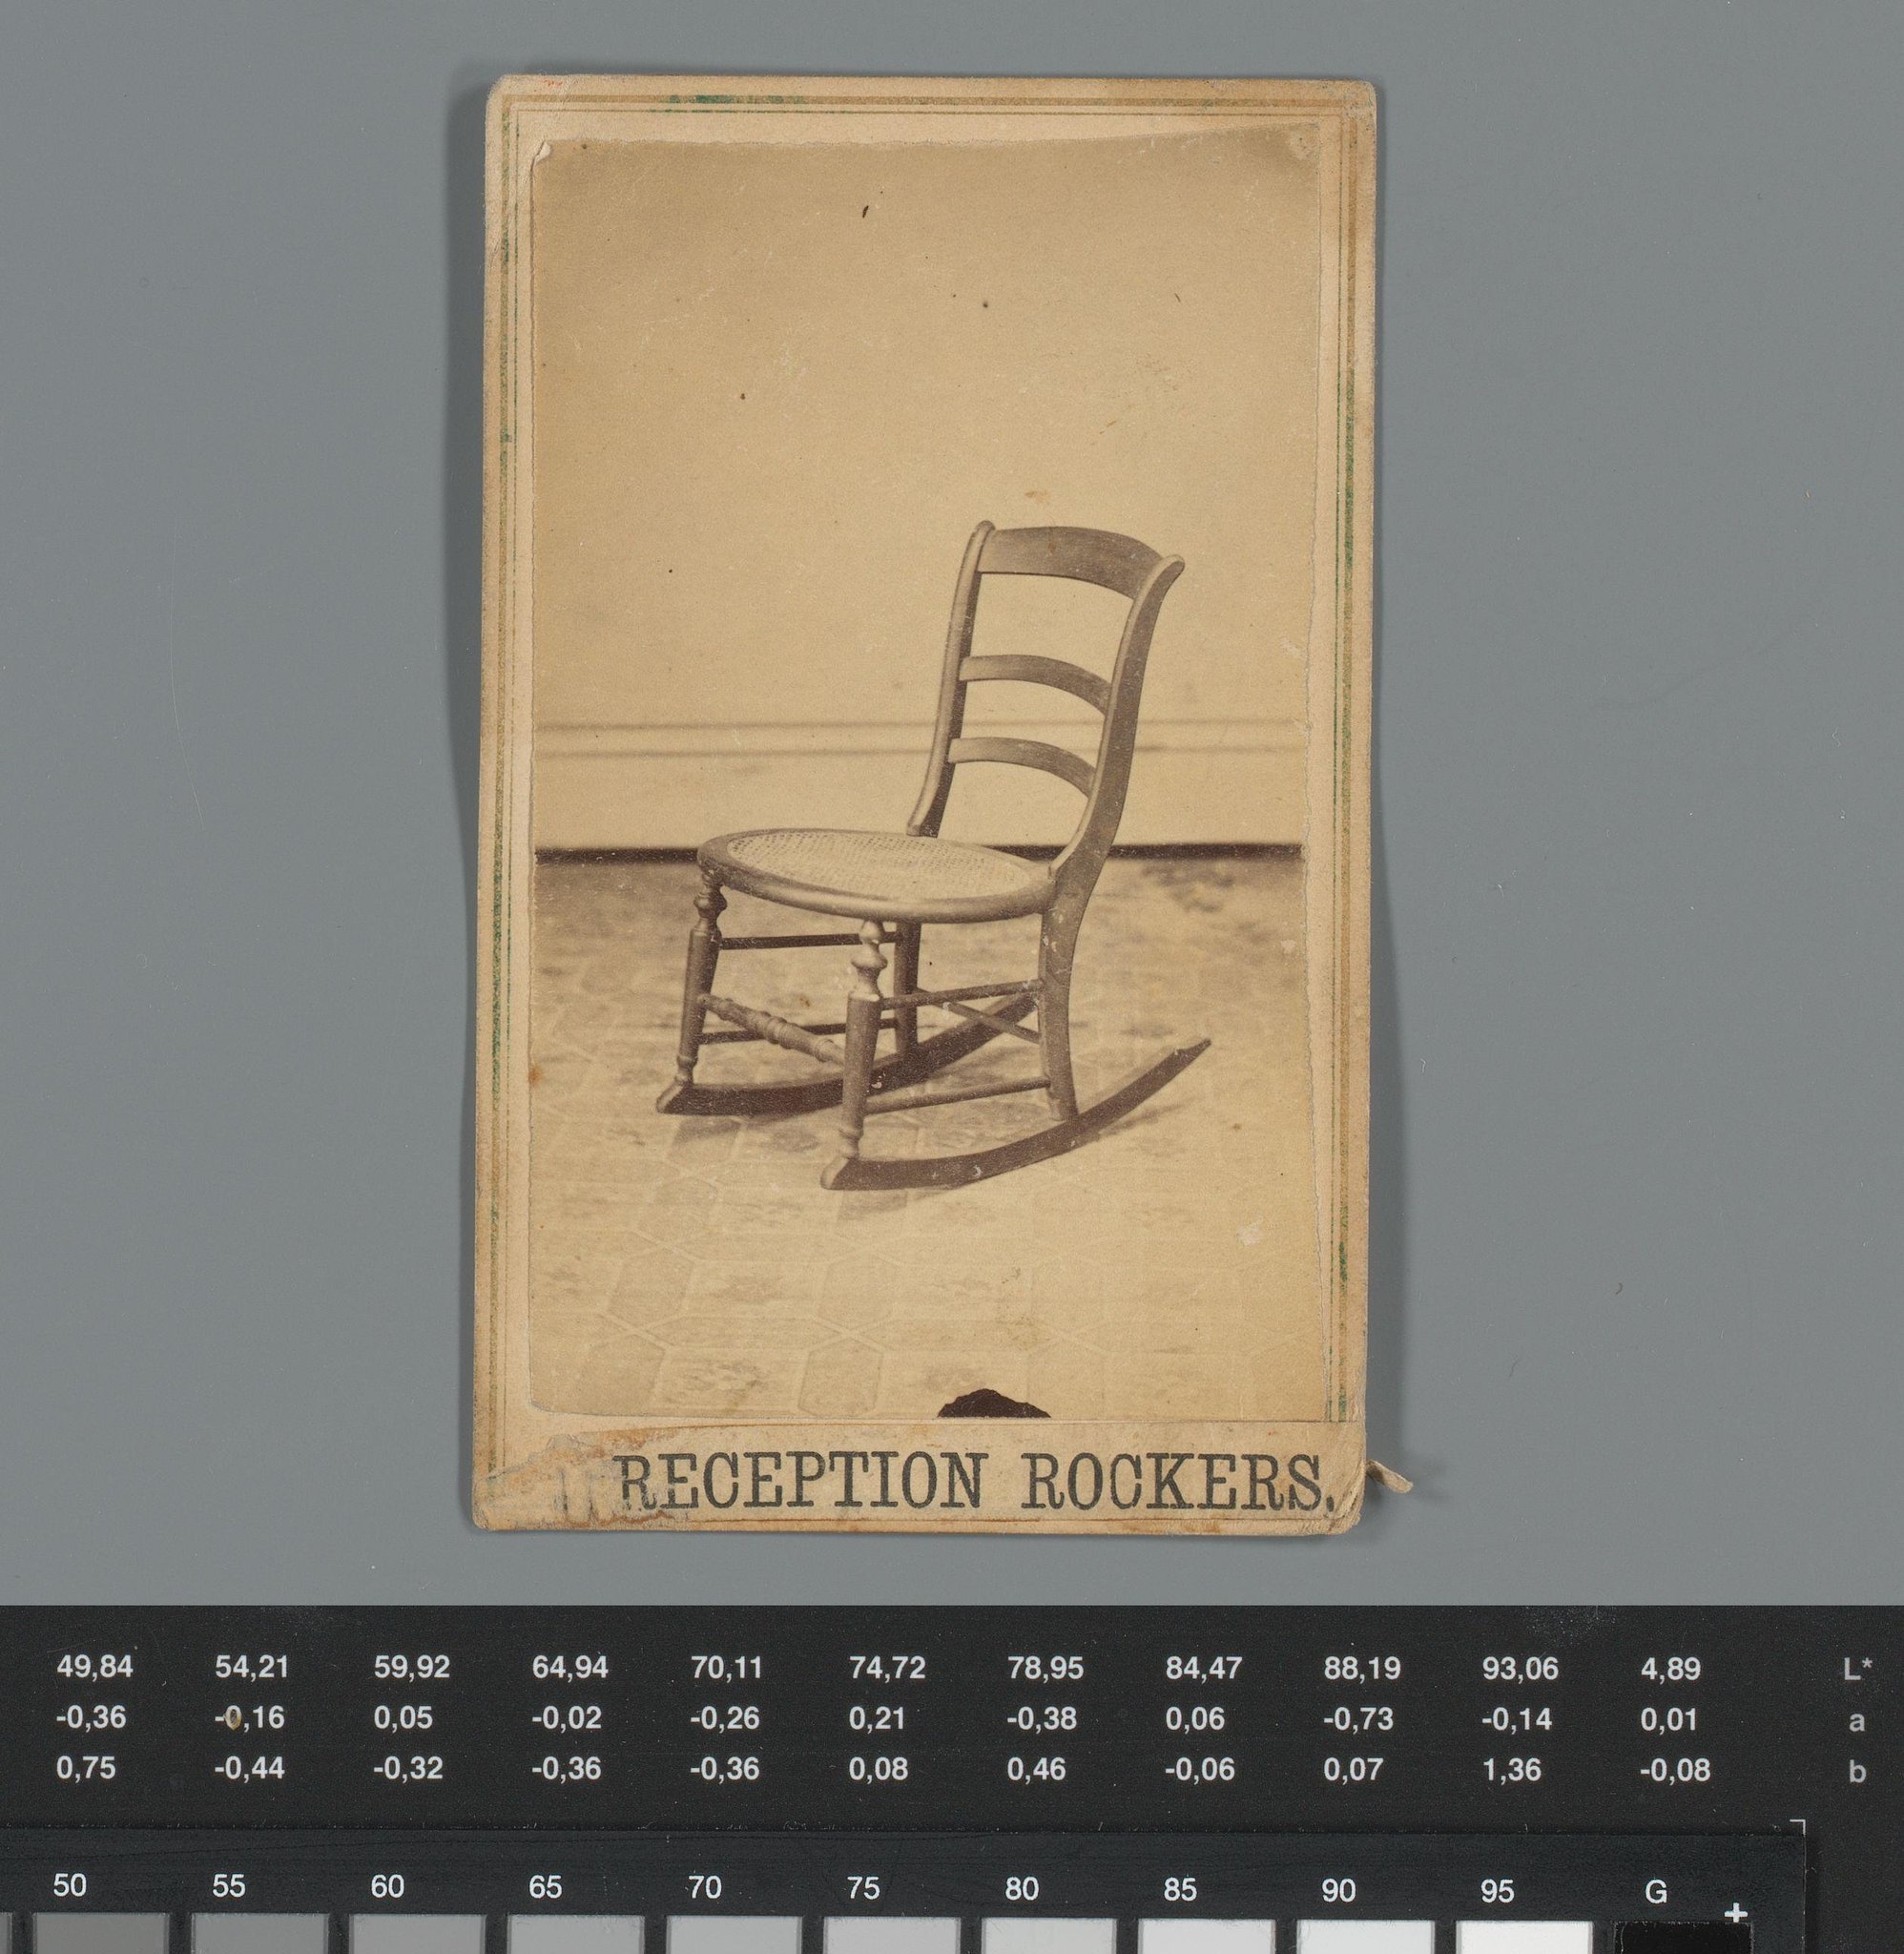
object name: carte de visite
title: Office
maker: Anonymous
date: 1850-1915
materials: cardboard, photographic support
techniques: albumen print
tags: advertising, chair